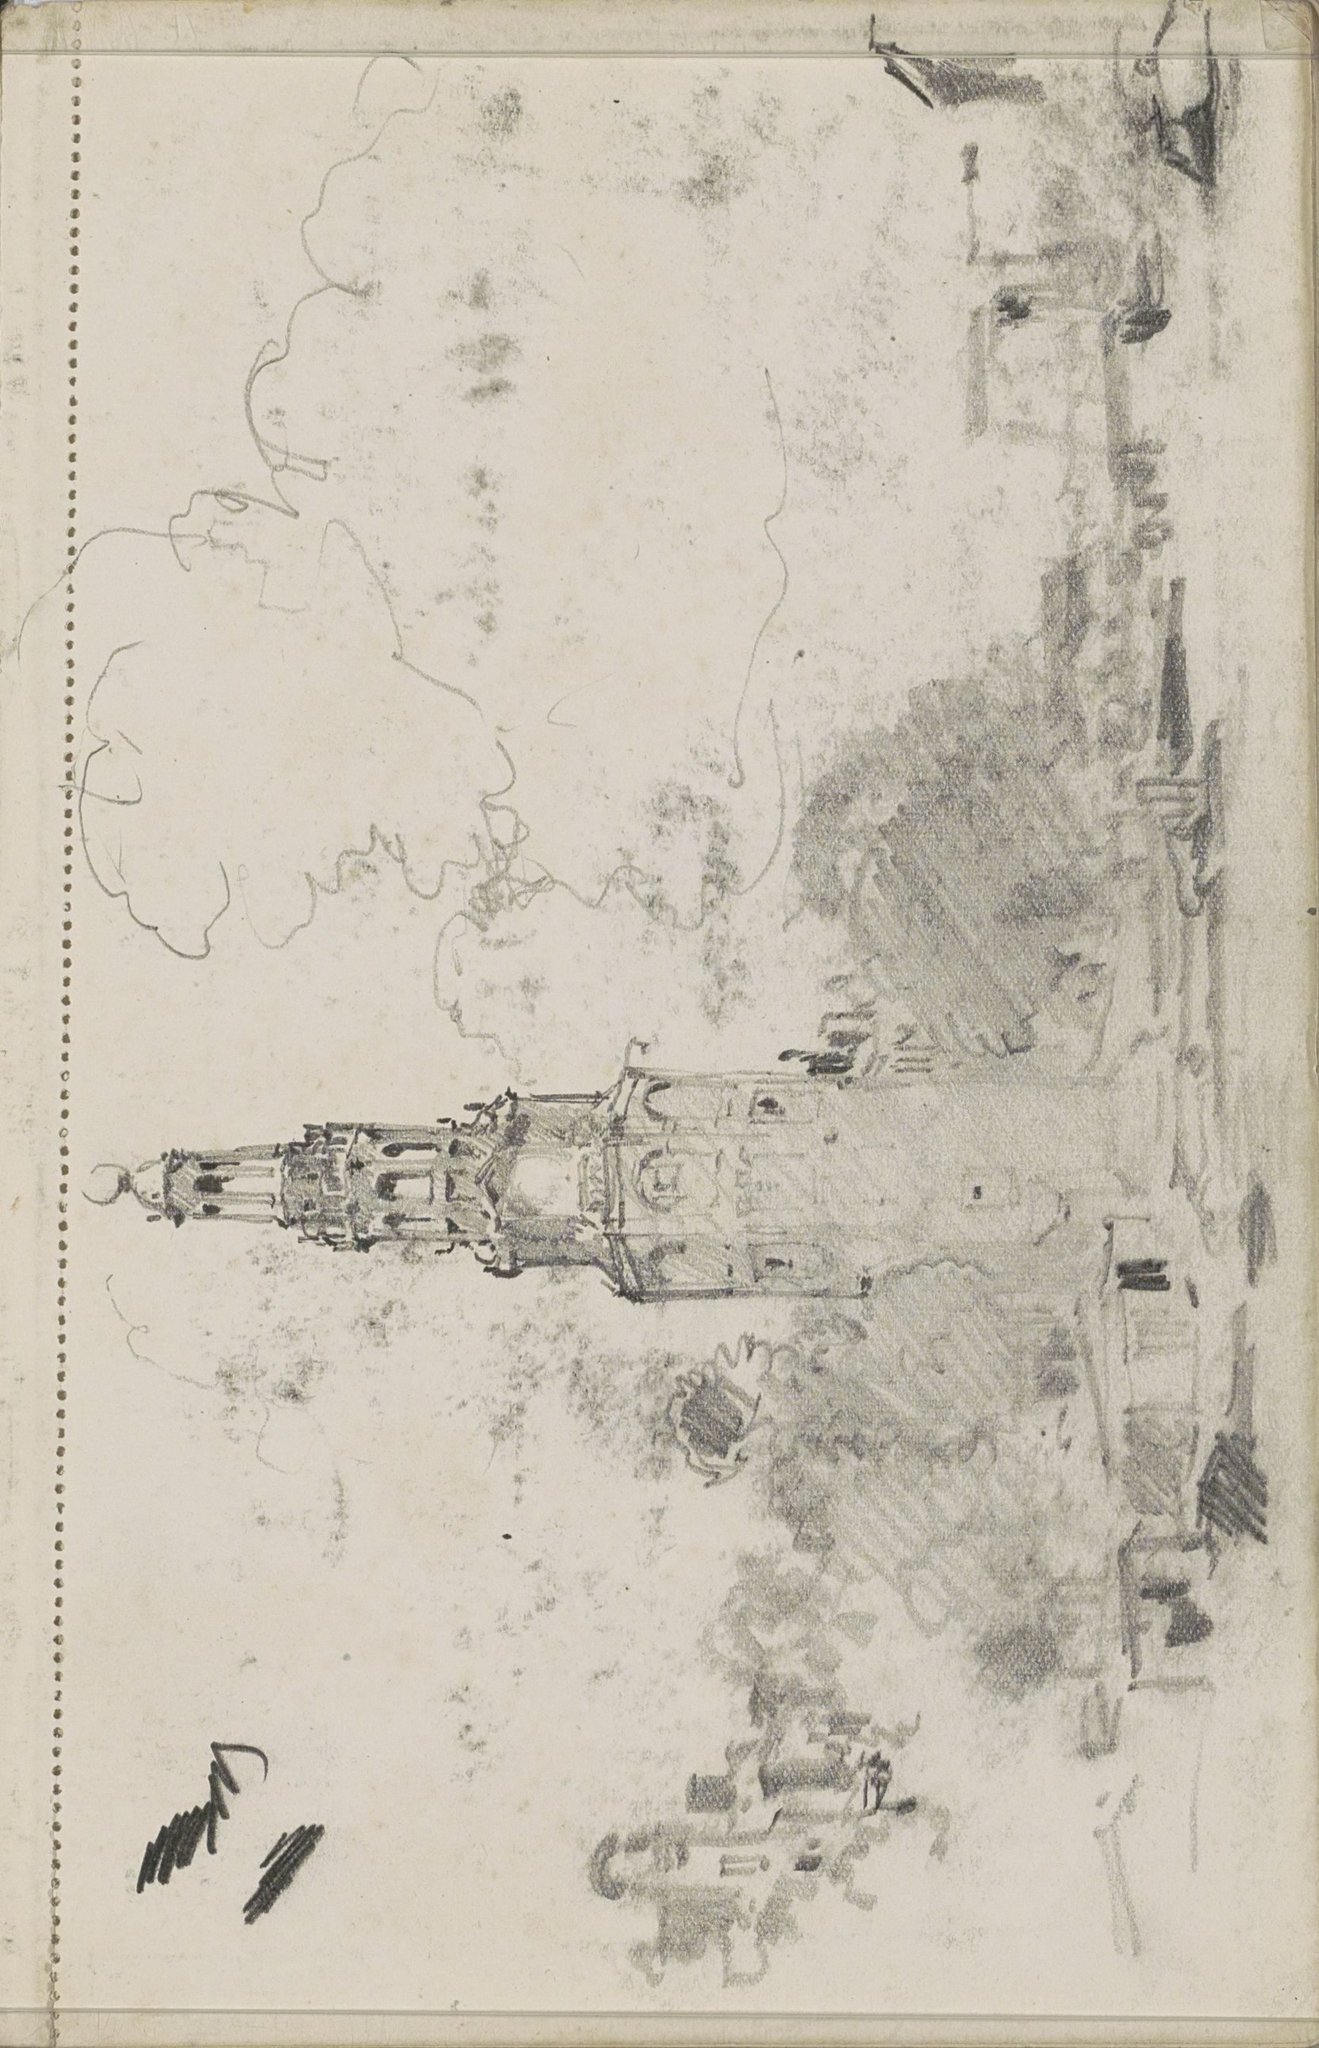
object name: sketchbook leaf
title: Zuiderkerk te Amsterdam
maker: cornelis vreedenburgh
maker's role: draughtsman, print maker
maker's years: 1880-1946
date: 1890-1946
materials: paper, pencil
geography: amsterdam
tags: church (exterior), street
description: Blad 1 recto uit een schetsboek met 61 bladen.